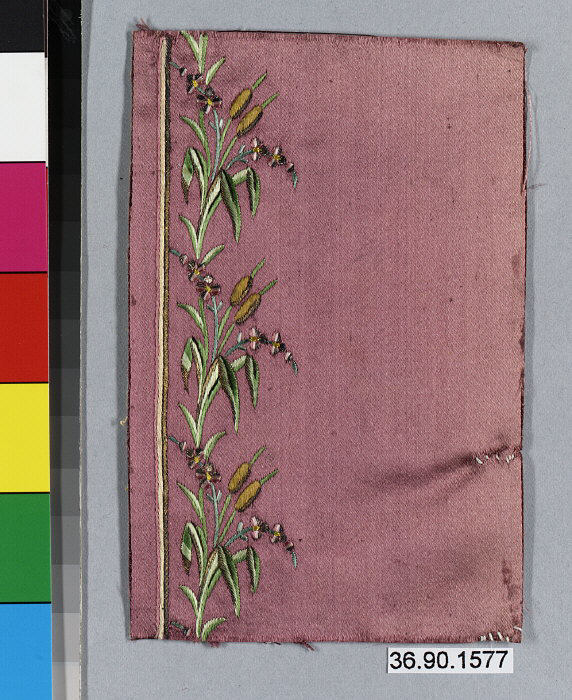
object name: sample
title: Embroidery sample for a man’s suit or waistcoat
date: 1785-1815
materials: metal thread, silk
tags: plants